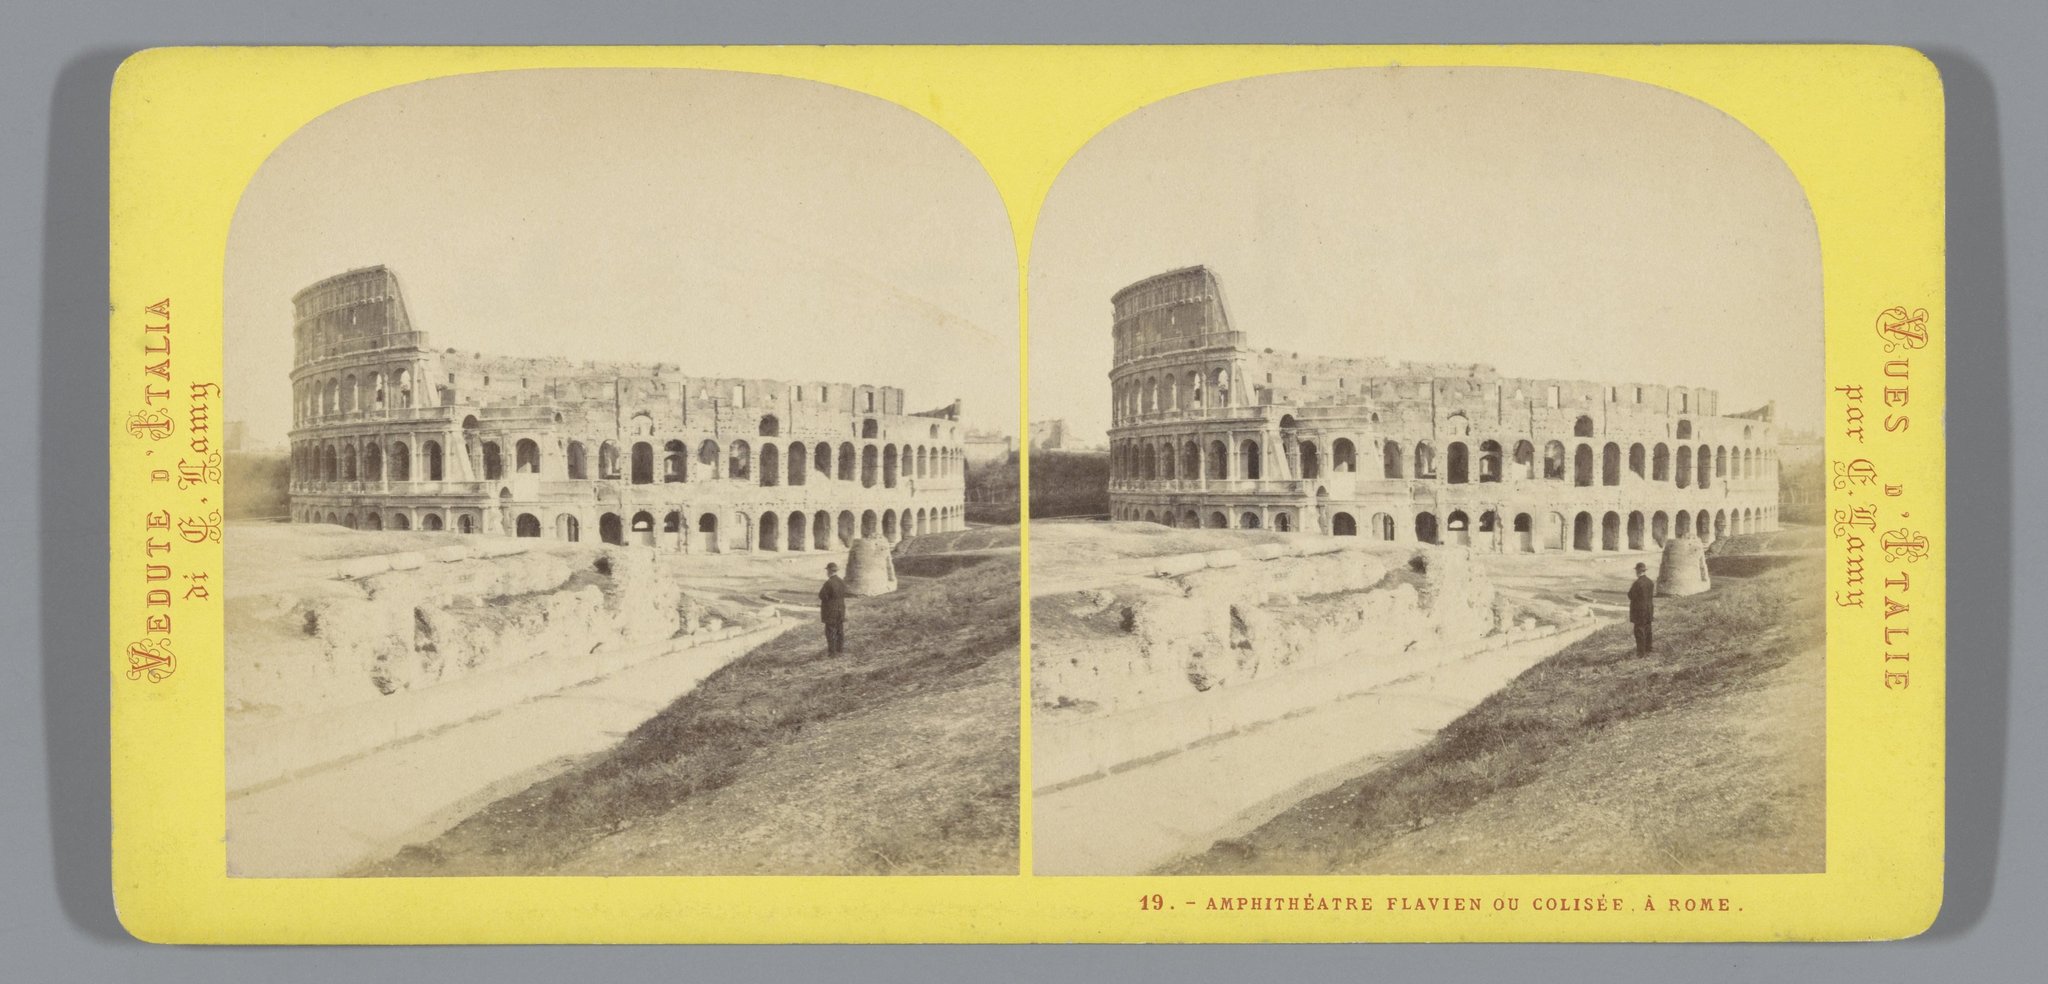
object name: stereograph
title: Vedute d'Italia / Vues d'Italie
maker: ernest eléonor pierre lamy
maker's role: publisher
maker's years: 1828-1900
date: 1861-1878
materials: cardboard, paper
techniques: albumen print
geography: rome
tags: amphitheatre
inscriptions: number: ‘19.’